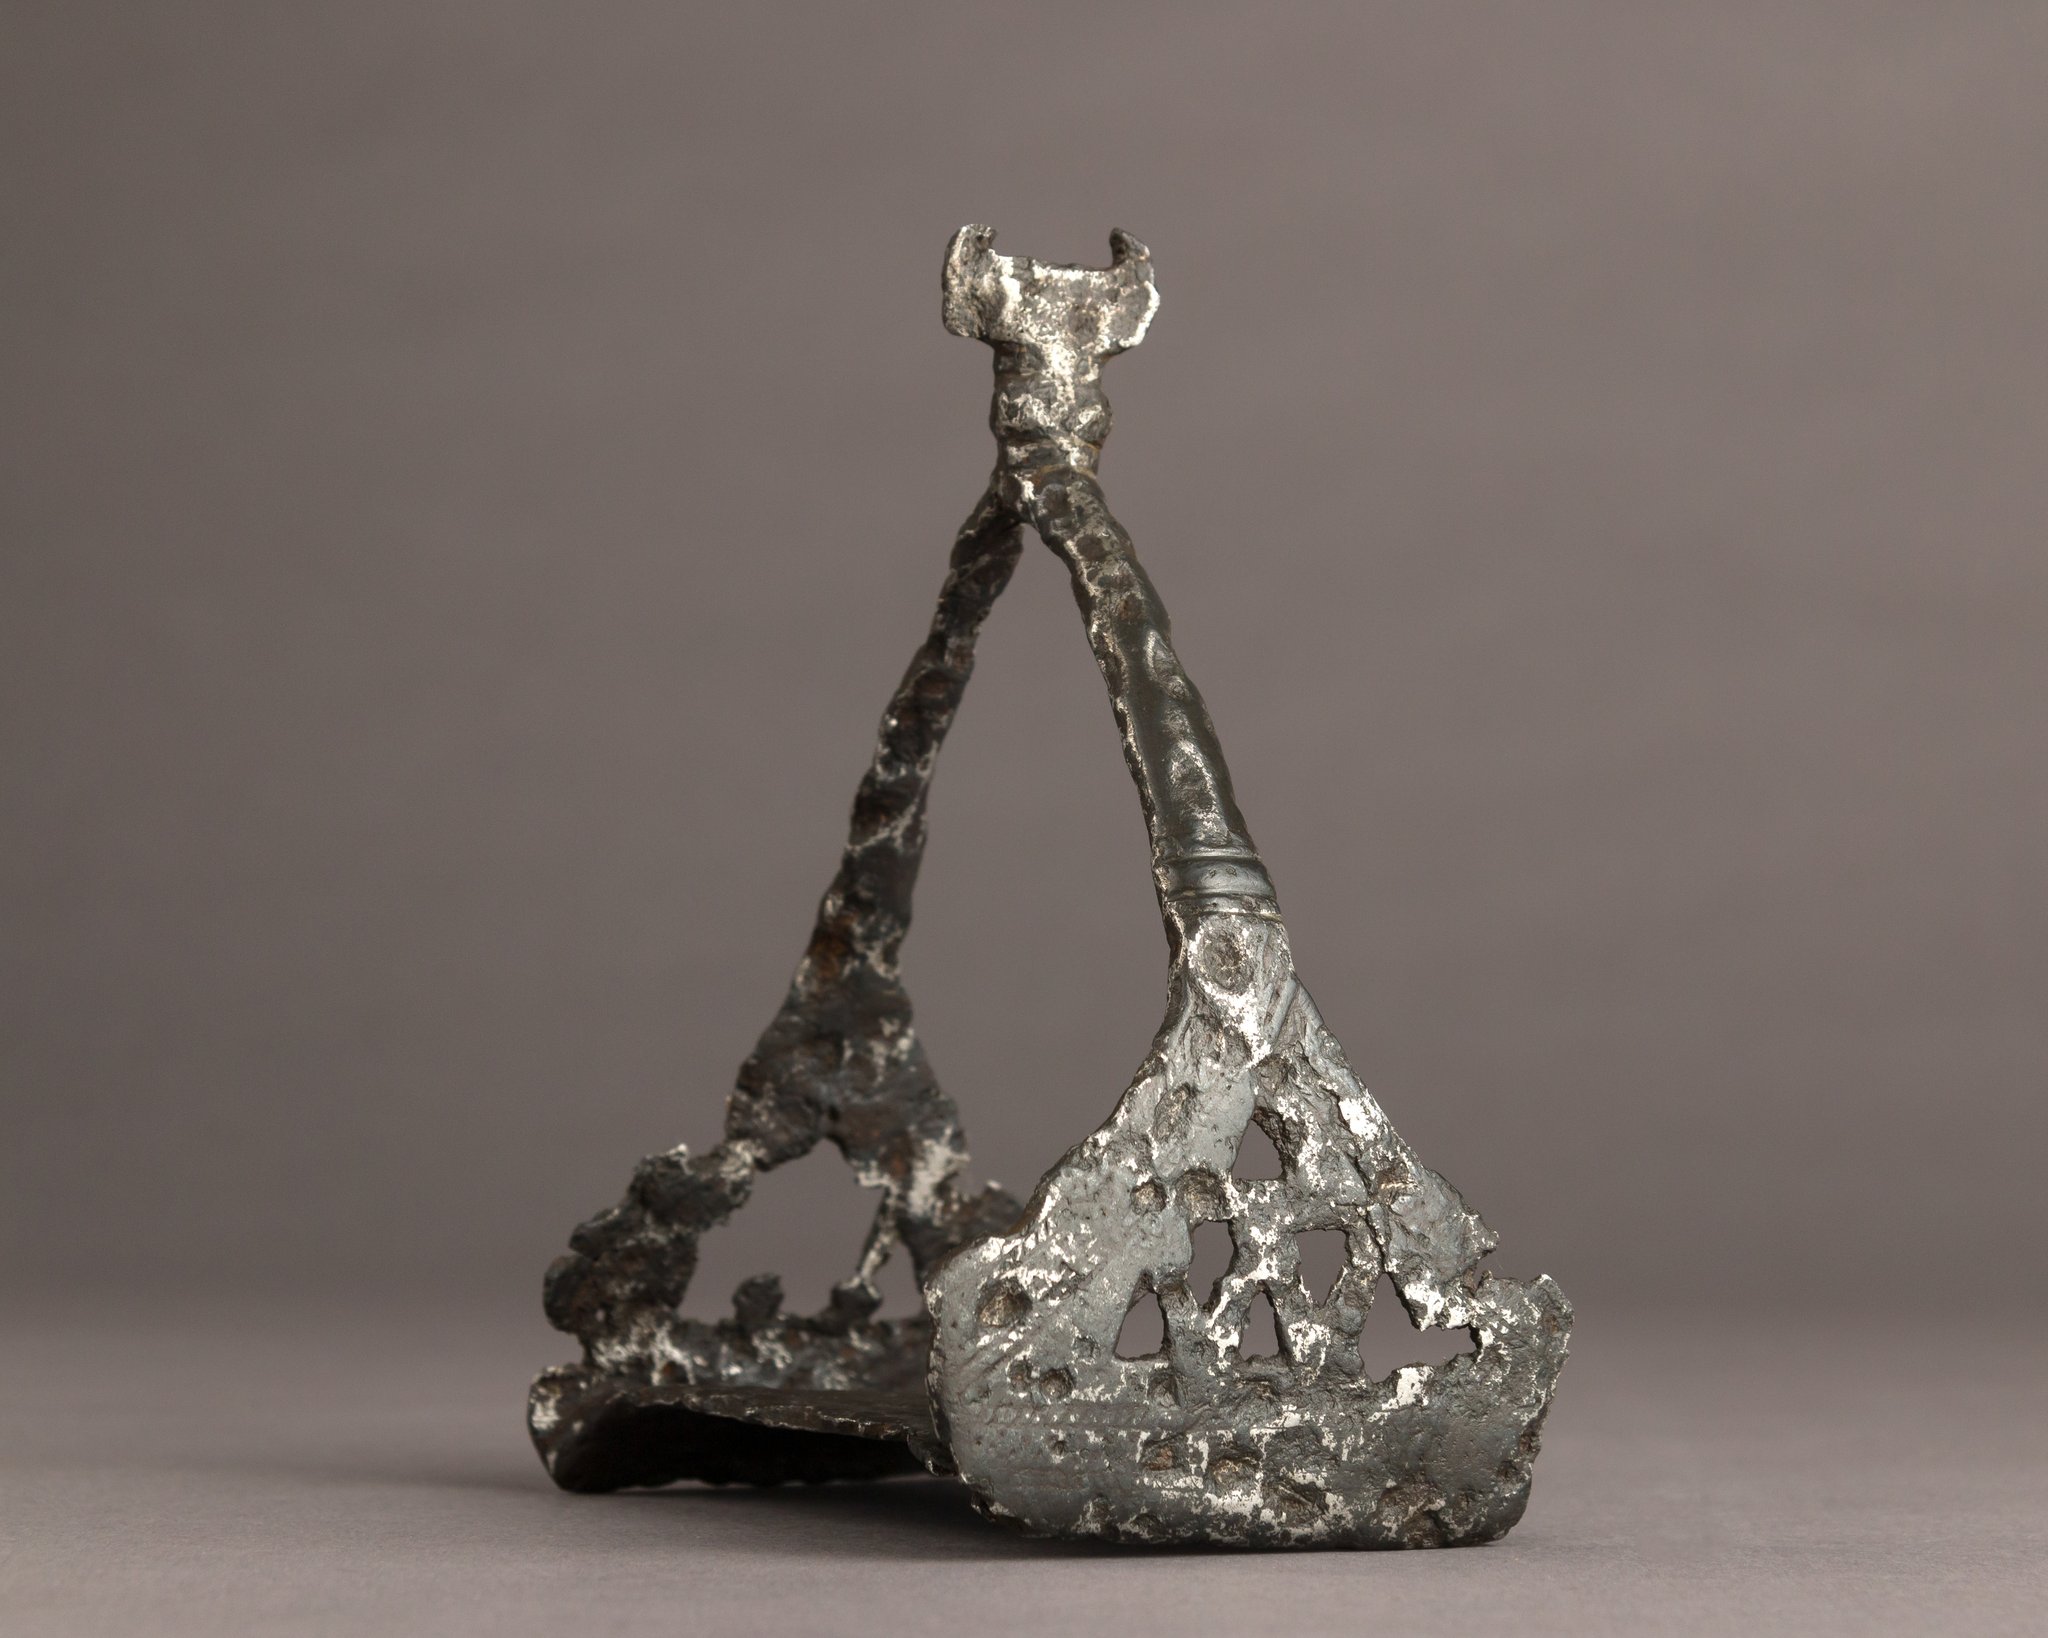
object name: stirrup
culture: germanic or slavic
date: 701-900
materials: iron, silver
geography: poland